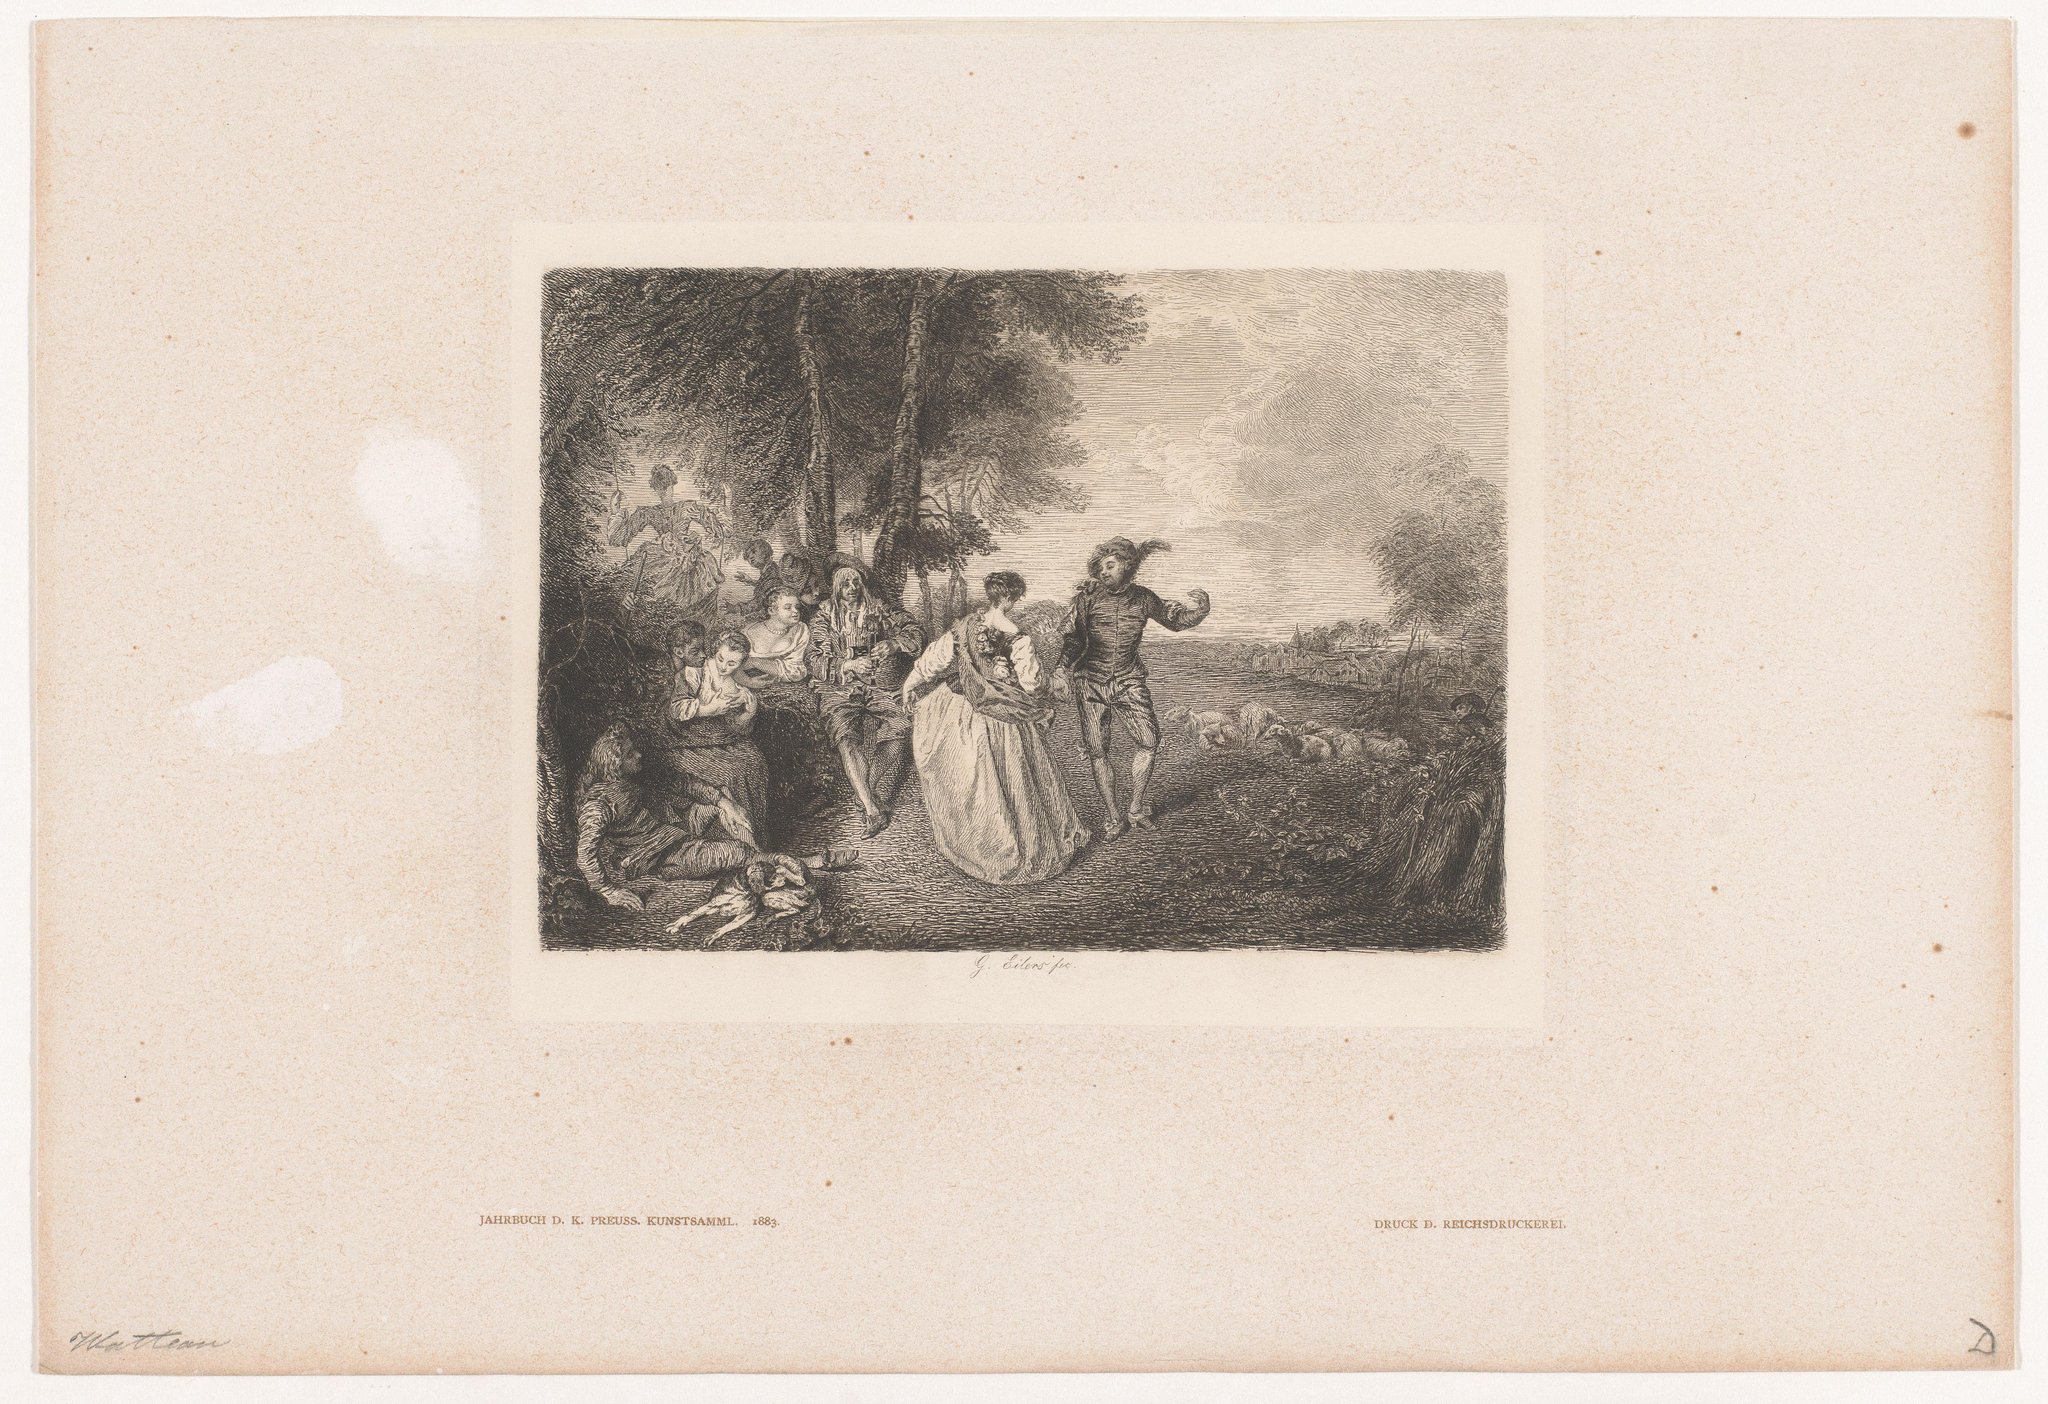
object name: print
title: Landschap met dansende herders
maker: gustav eilers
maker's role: print maker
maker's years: 1834-1911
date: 1844-1911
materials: paper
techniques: etching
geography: berlin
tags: landscapes, herding, herdsman, herdswoman, shepherd, shepherdess, cowherd, etc., one pair dancing; man and woman dancing as a couple, swing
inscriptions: collector's mark: Lugt 2228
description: Prent gebruikt voor: Jahrbuch der Königlich Preussischen Kunstsammlungen. Berlijn: Weidmannsche Buchhandlung, 1883.